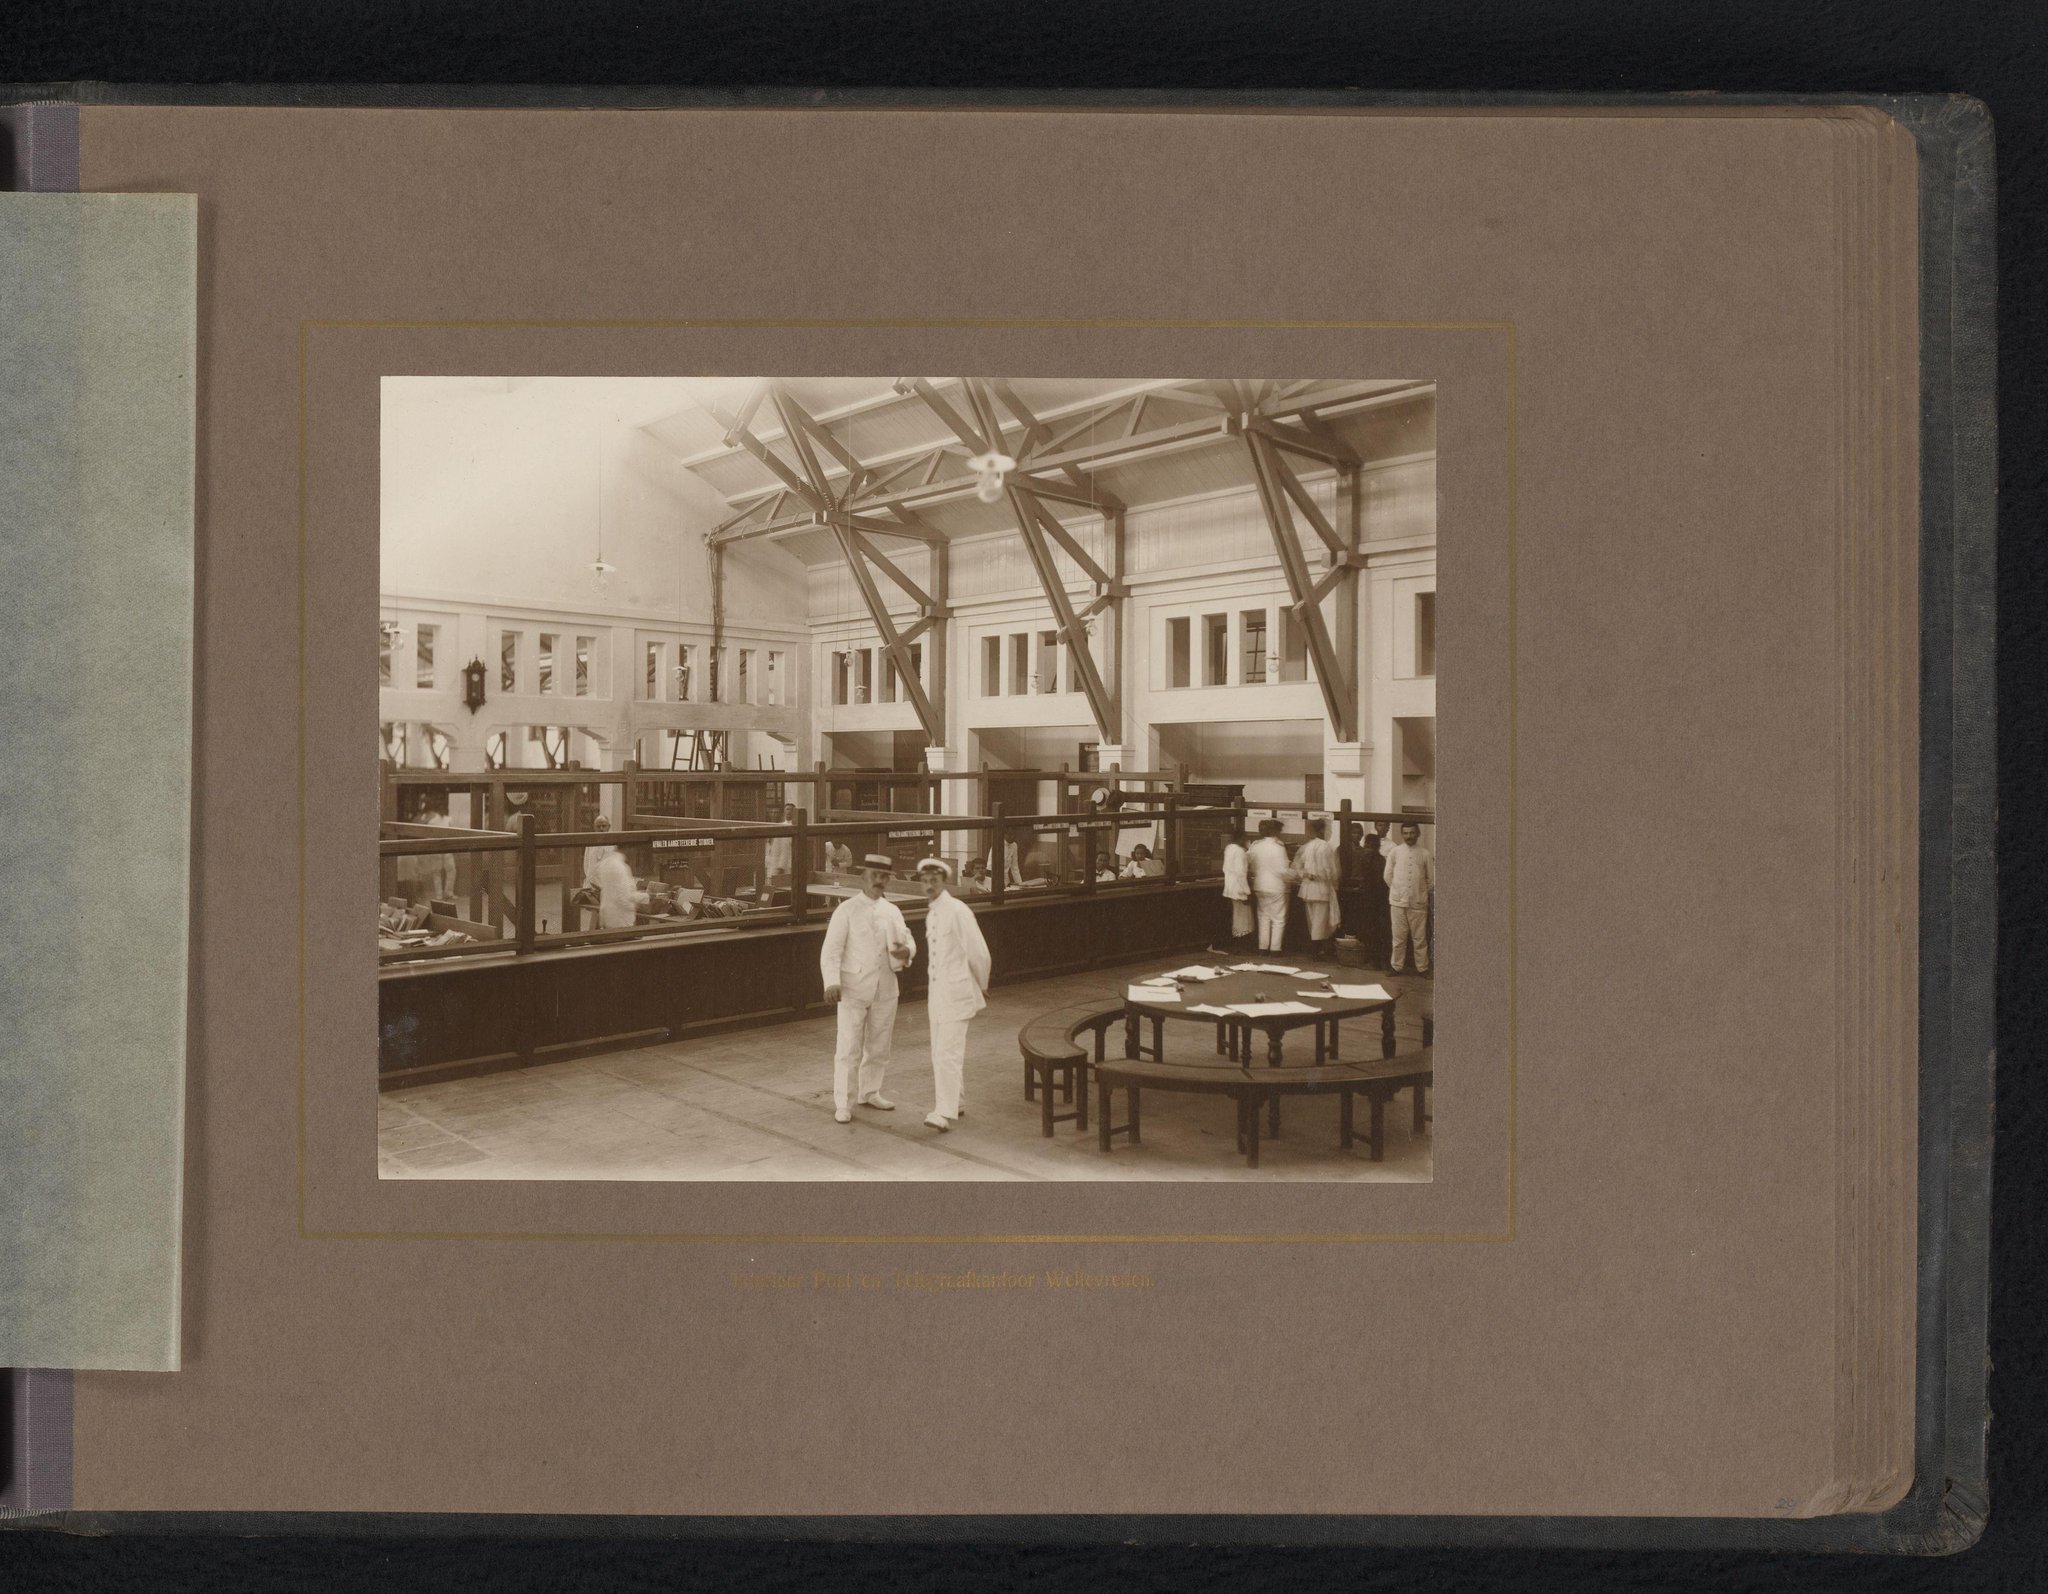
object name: photograph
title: Interieur Post en Telegraafkantoor Weltevreden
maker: Anonymous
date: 1918-1919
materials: photographic support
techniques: gelatin silver print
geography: batavia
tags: edifice, e.g.: public building, department store - aa - civic architecture: inside, post-office, batavia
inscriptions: inscription: ‘Interieur Post en Telegraafkantoor Weltevreden’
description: Het interieur van het Post- en Telegraafkantoor te Weltevreden, in bedrijf met klanten. Onderdeel van het fotoalbum van de Eerste Waterstaatsafdeling op West-Java 22 maart 1915 - 30 juli 1919.